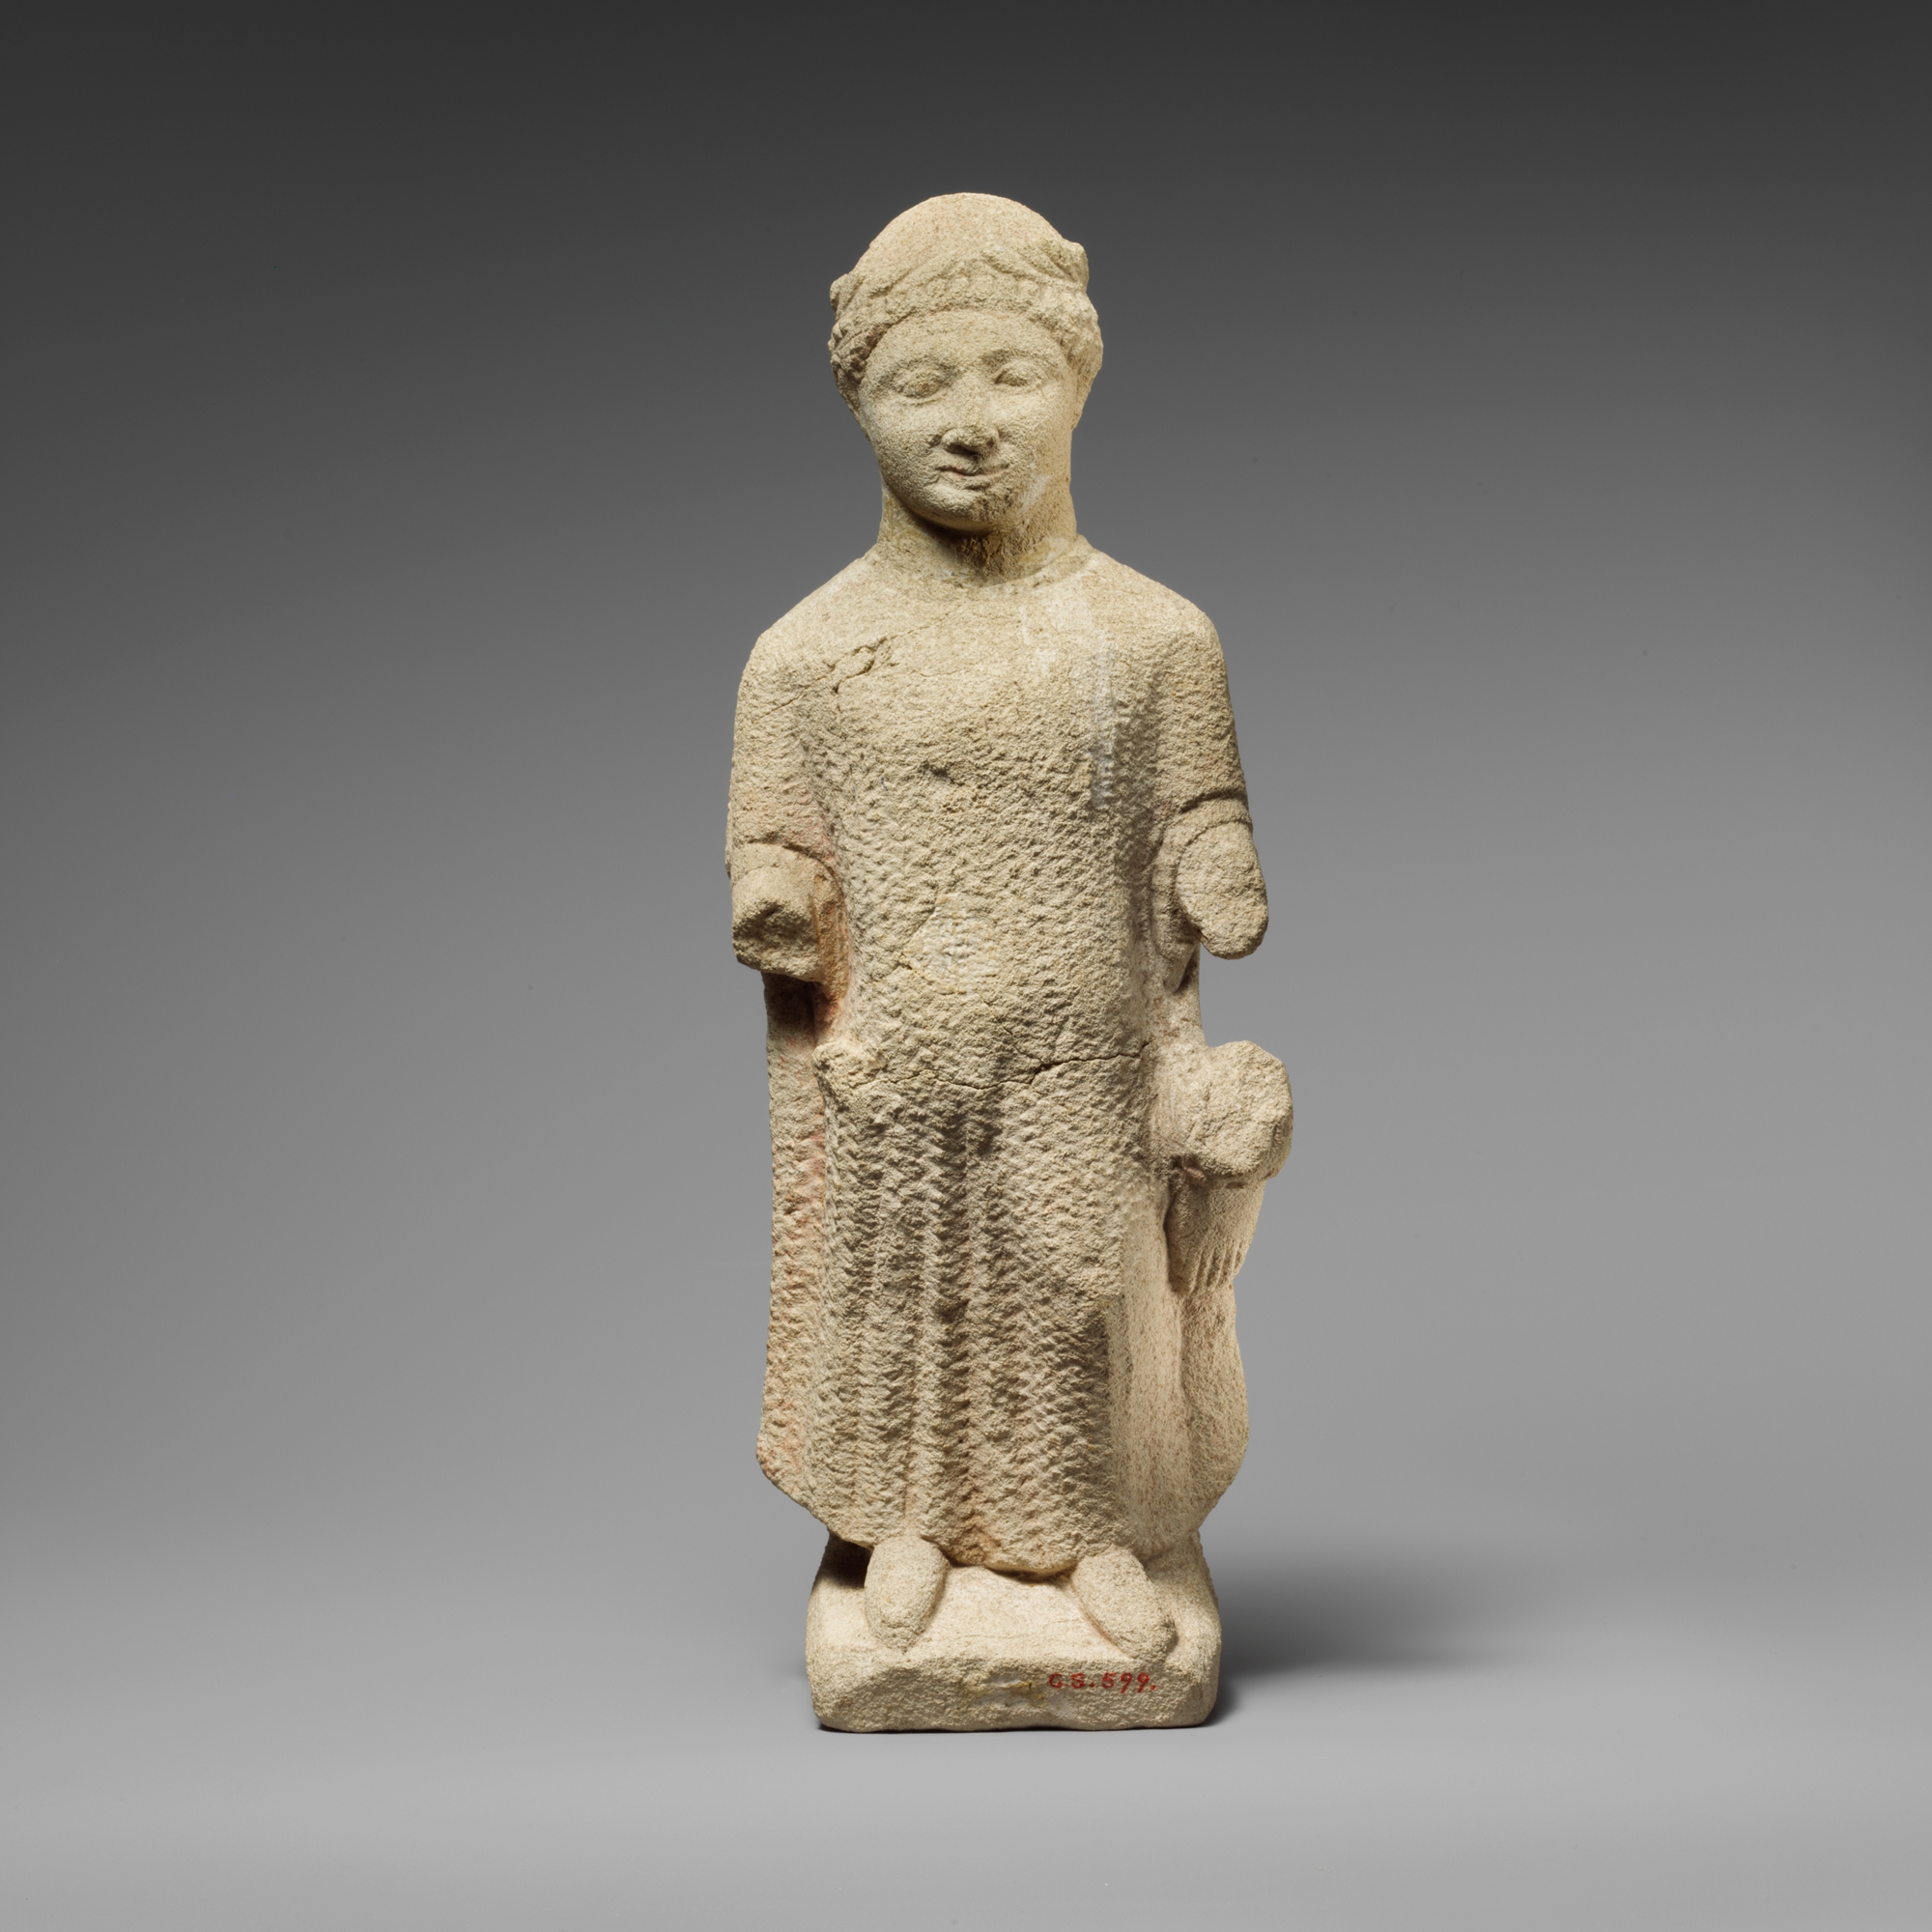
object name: statue of a votary, young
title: Limestone statuette of a boy holding a bird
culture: cypriot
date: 450-401 BCE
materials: limestone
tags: boys